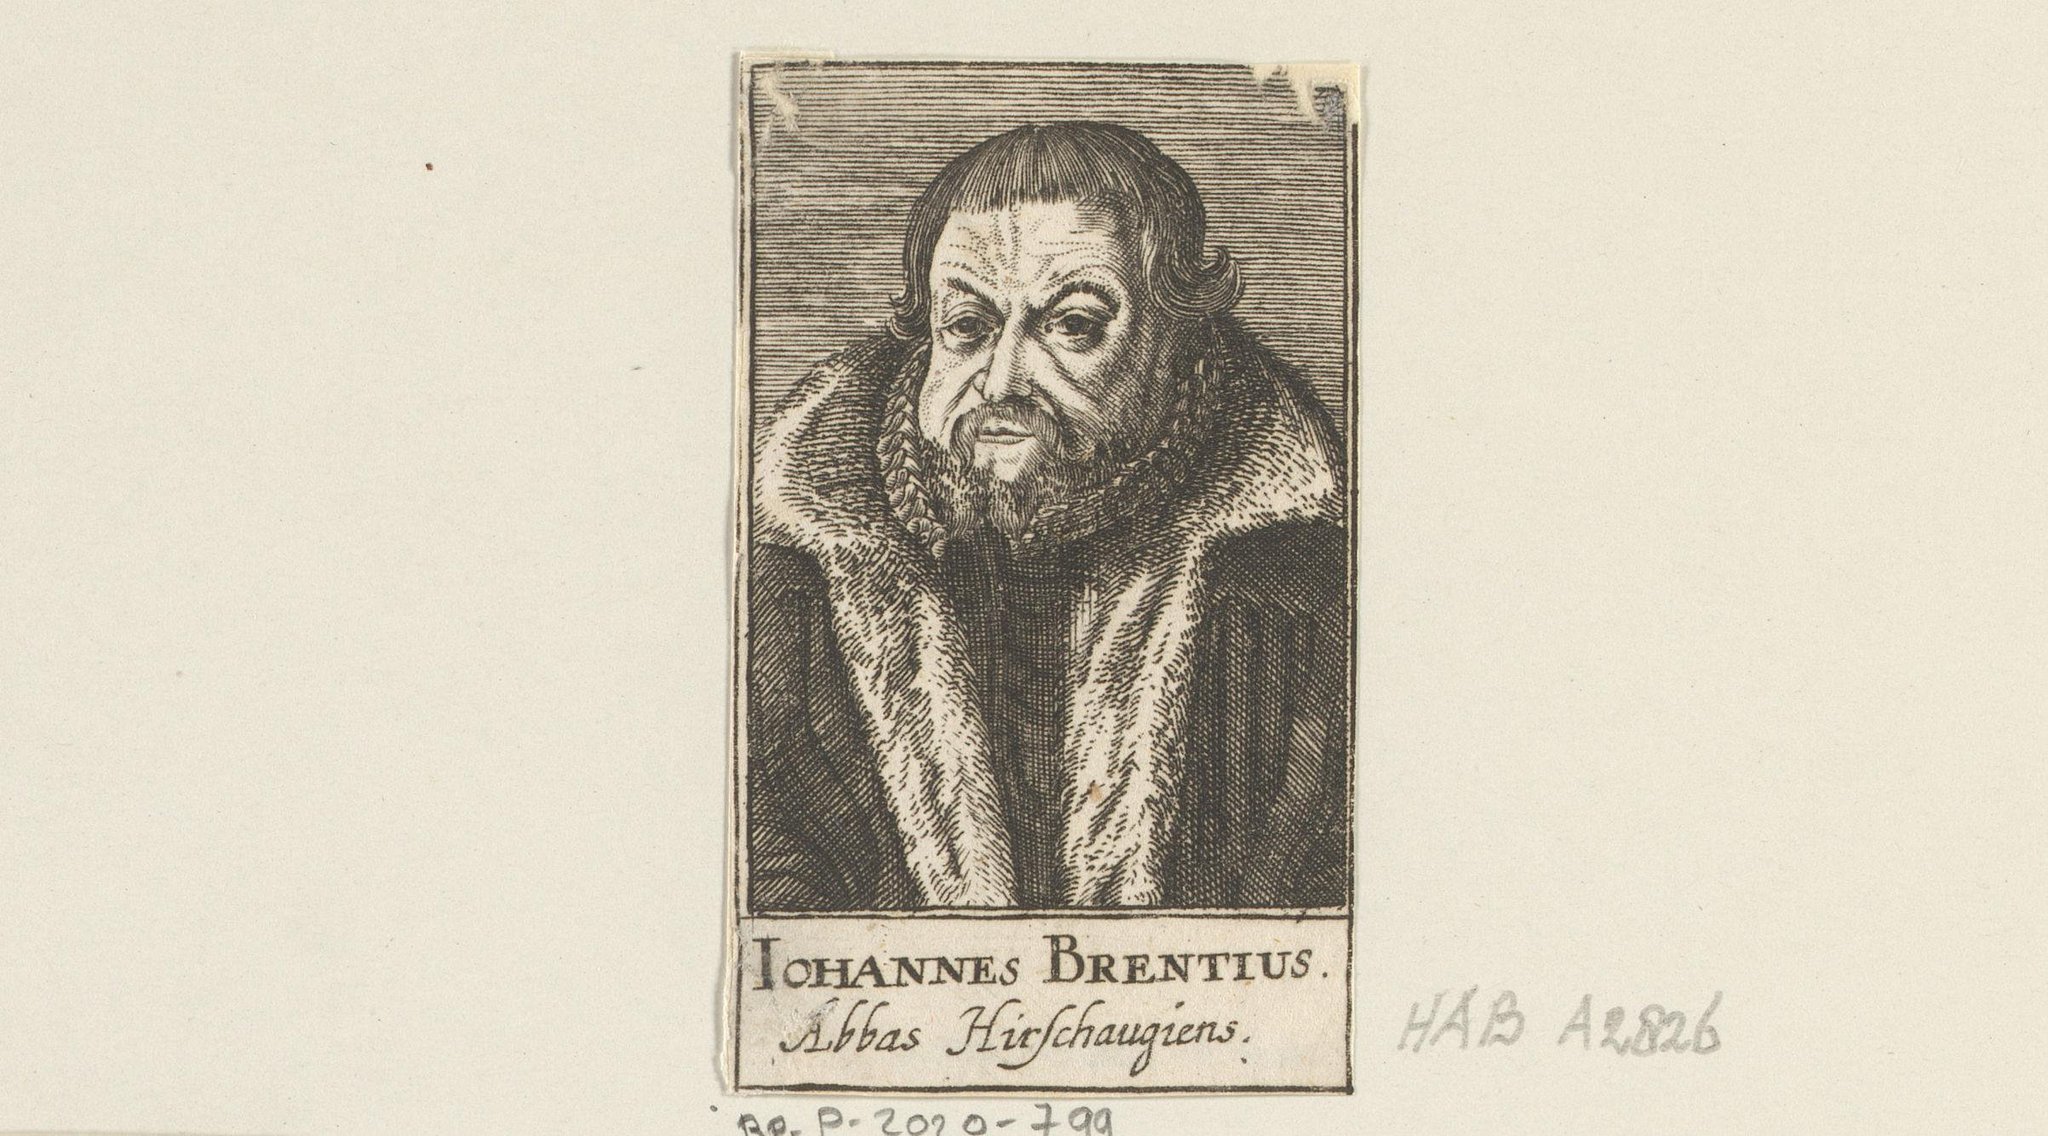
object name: print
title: Johannes Brentius abbas Hirschaugiens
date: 1688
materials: paper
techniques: engraving, etching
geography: nuremberg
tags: theologian, historical persons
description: Prent uit: Freher, Paul. Theatrum virorum eruditione clarorum. Neurenberg: Johann Hoffmann, 1688.